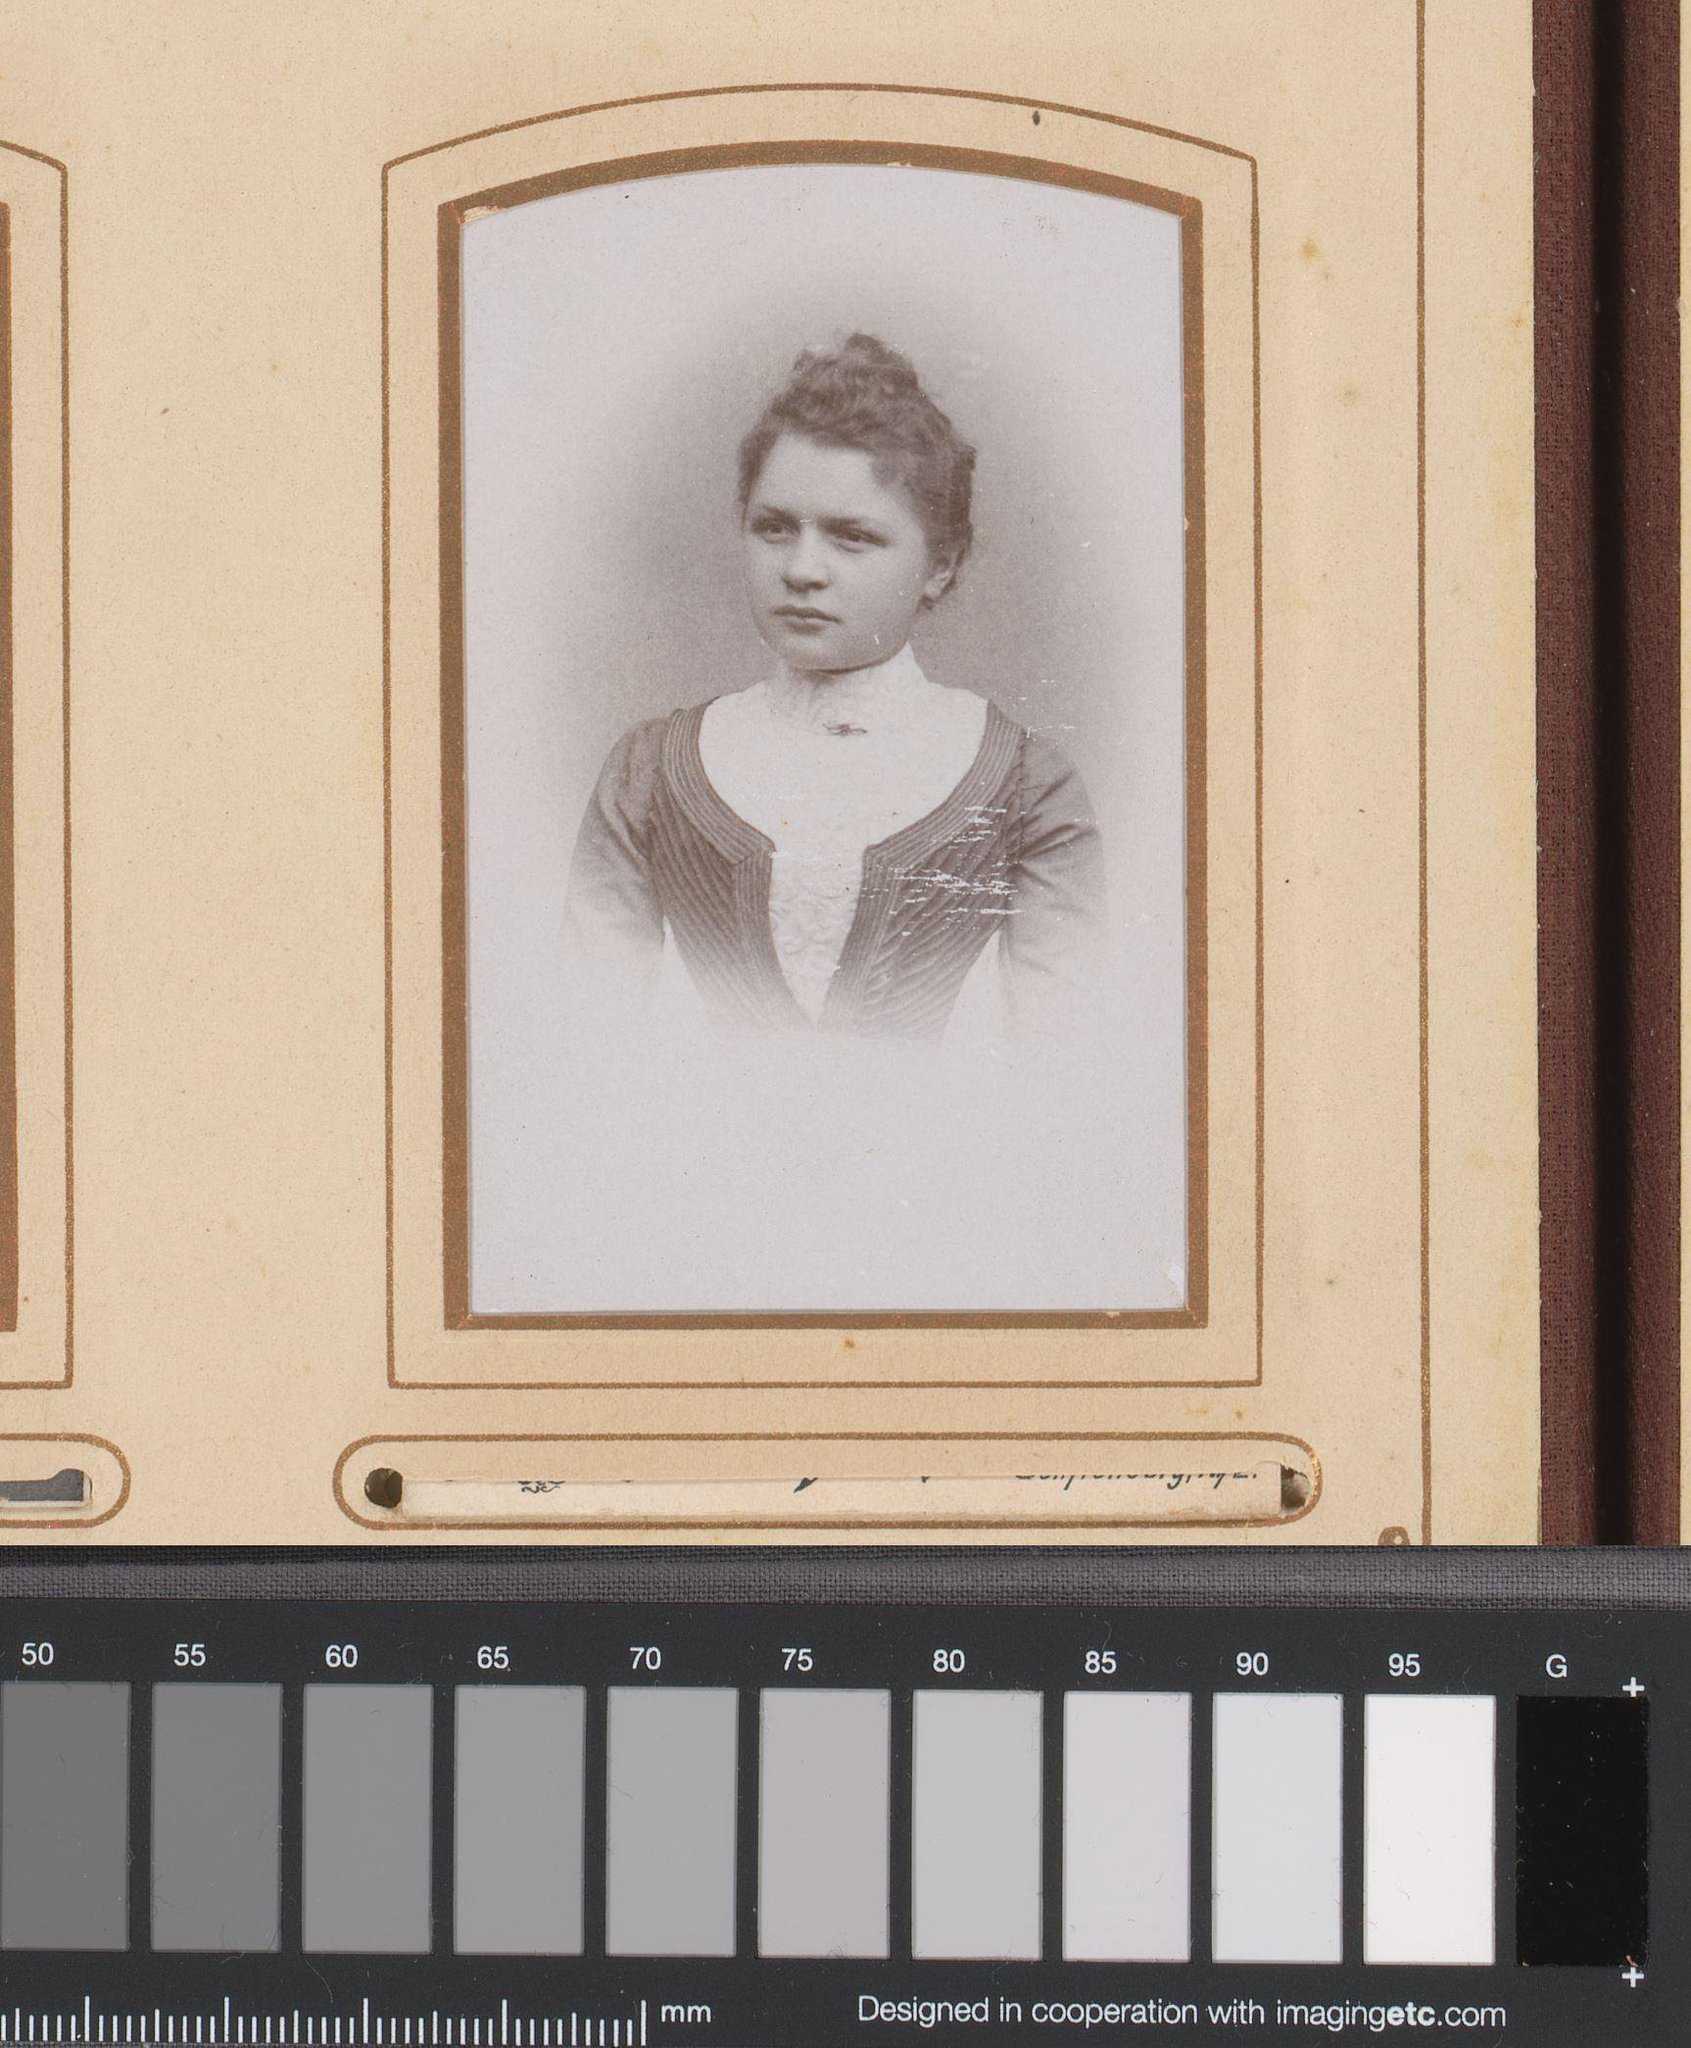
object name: carte de visite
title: Portret van een meisje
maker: hermann meyer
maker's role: fotograaf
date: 1881-1910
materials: cardboard, photographic support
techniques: collodion silver print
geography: senftenberg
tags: historical persons - bb - woman, girl (child between toddler and youth)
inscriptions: inscription: ‘Photographisches Atelier/ gegründet 1881/ Herm. Meyer/ Senftenberg N.L.’